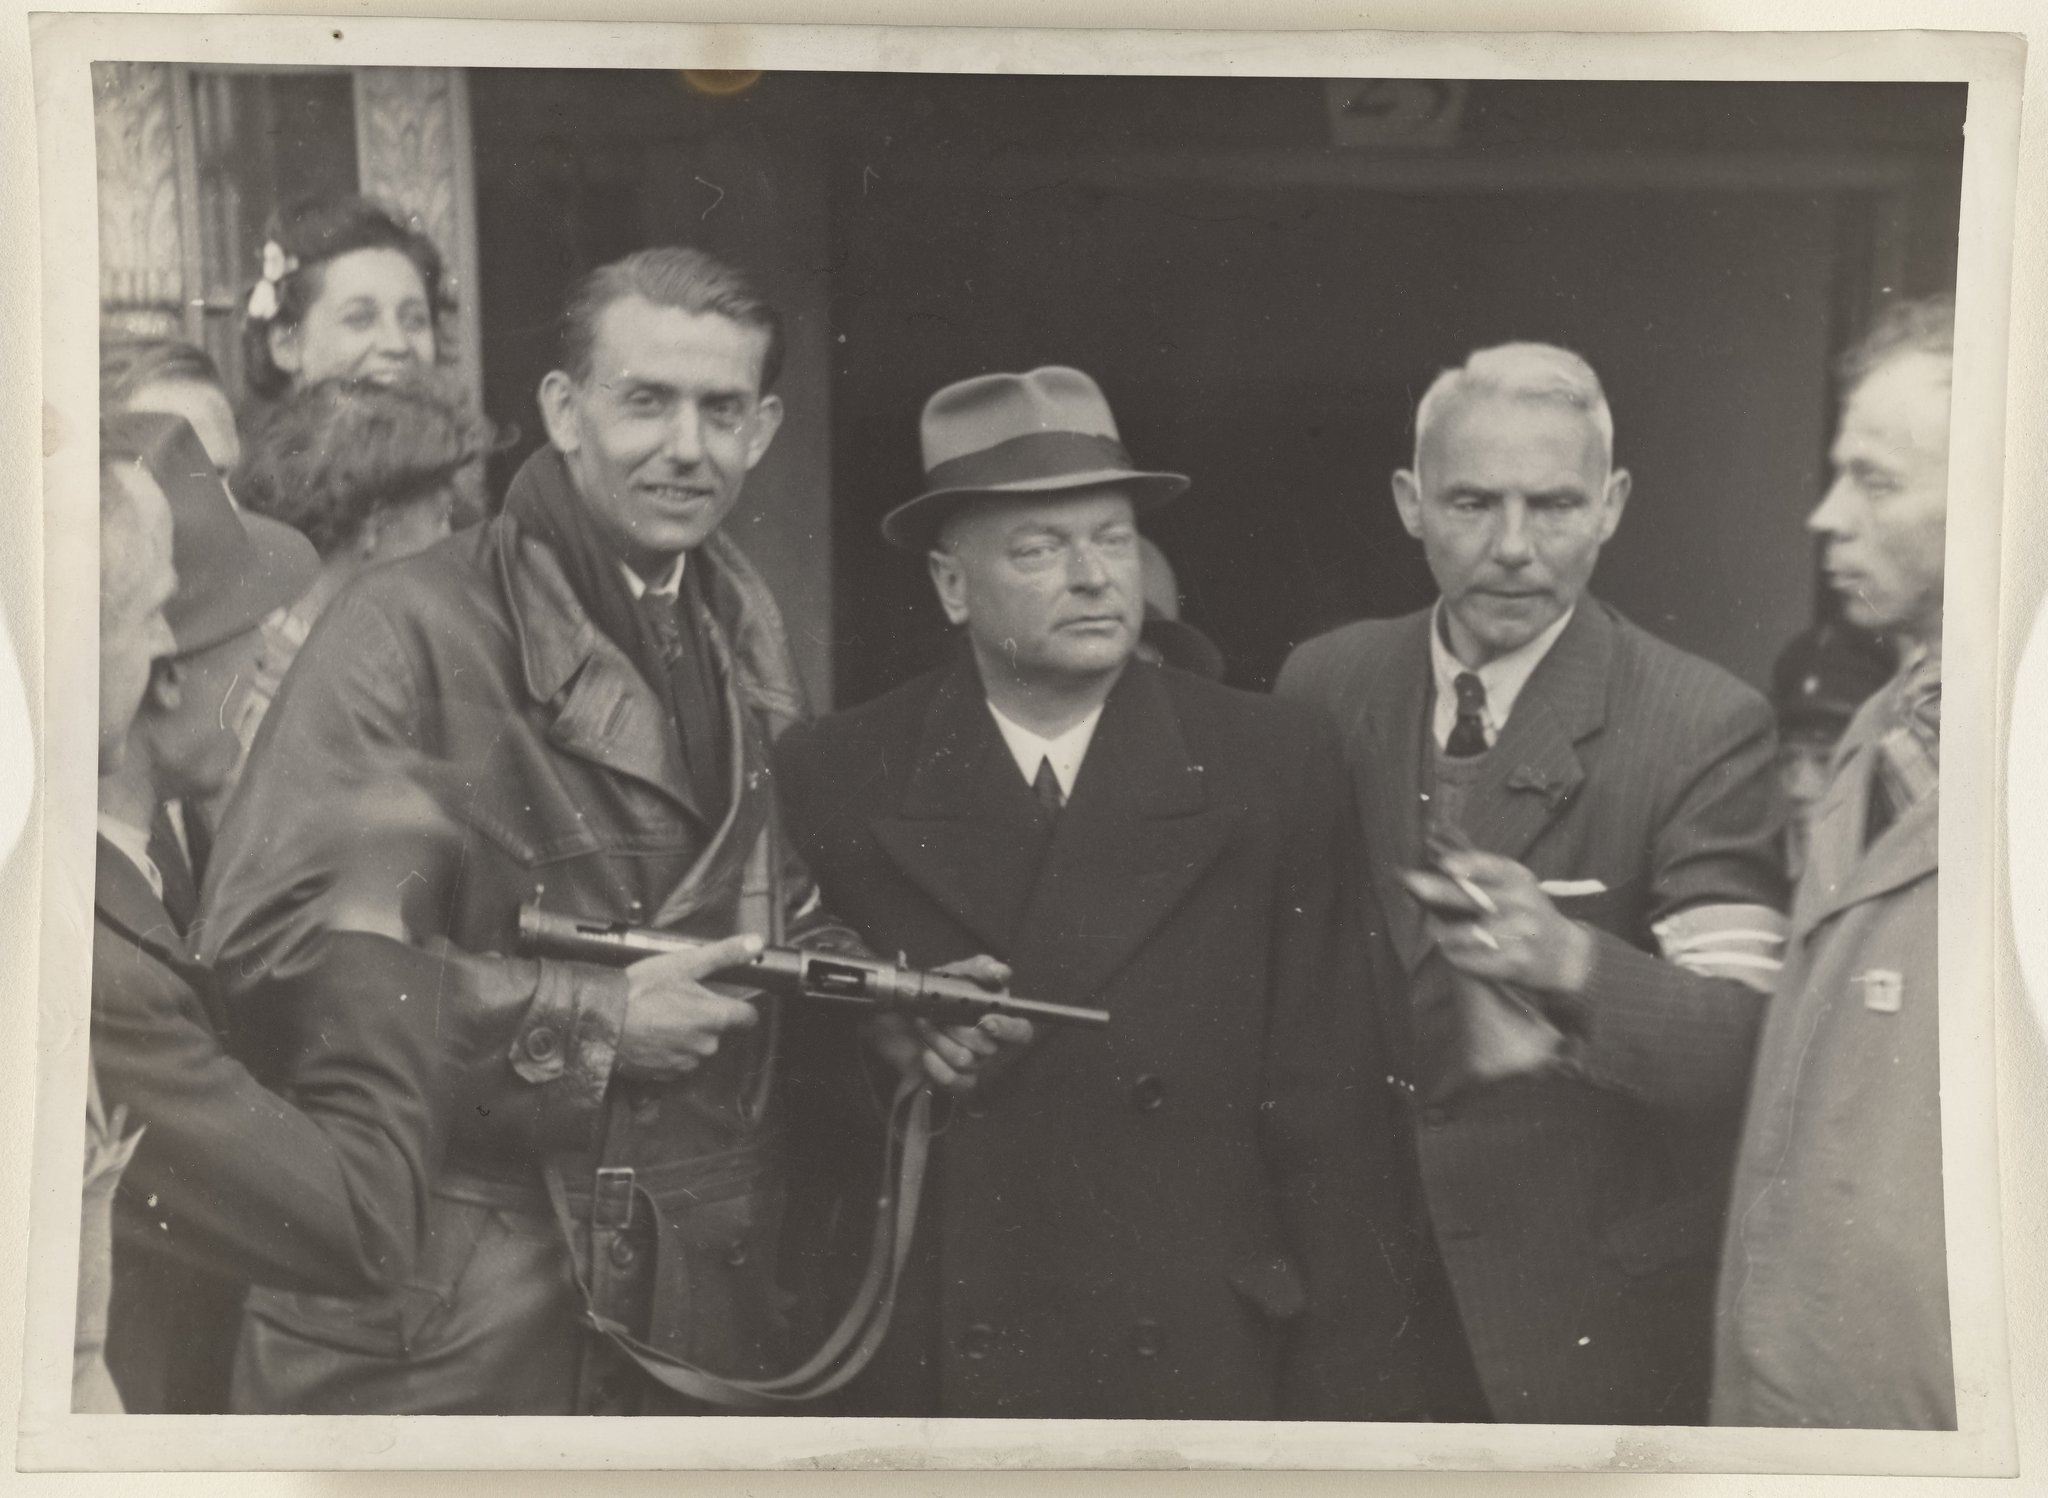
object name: photograph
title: Arrestatie van Mussert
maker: Anonymous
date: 1945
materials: photographic support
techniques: photography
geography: the hague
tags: politician, anton adriaan mussert, the hague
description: Arrestatie van Anton Mussert, leider van de NSB op de Korte Vijverberg 3 te Den Haag (het Groen van Prinstererhuis) op 7 mei 1945. Op 7 mei 1946 werd hij gefusilleerd. Rechts van Mussert is Johann Gottlieb Crabbendam, met armband. De persoon uiterst rechts is vermoedelijk de net aangestelde Haagse hoofdcommissaris G.W. Valken.